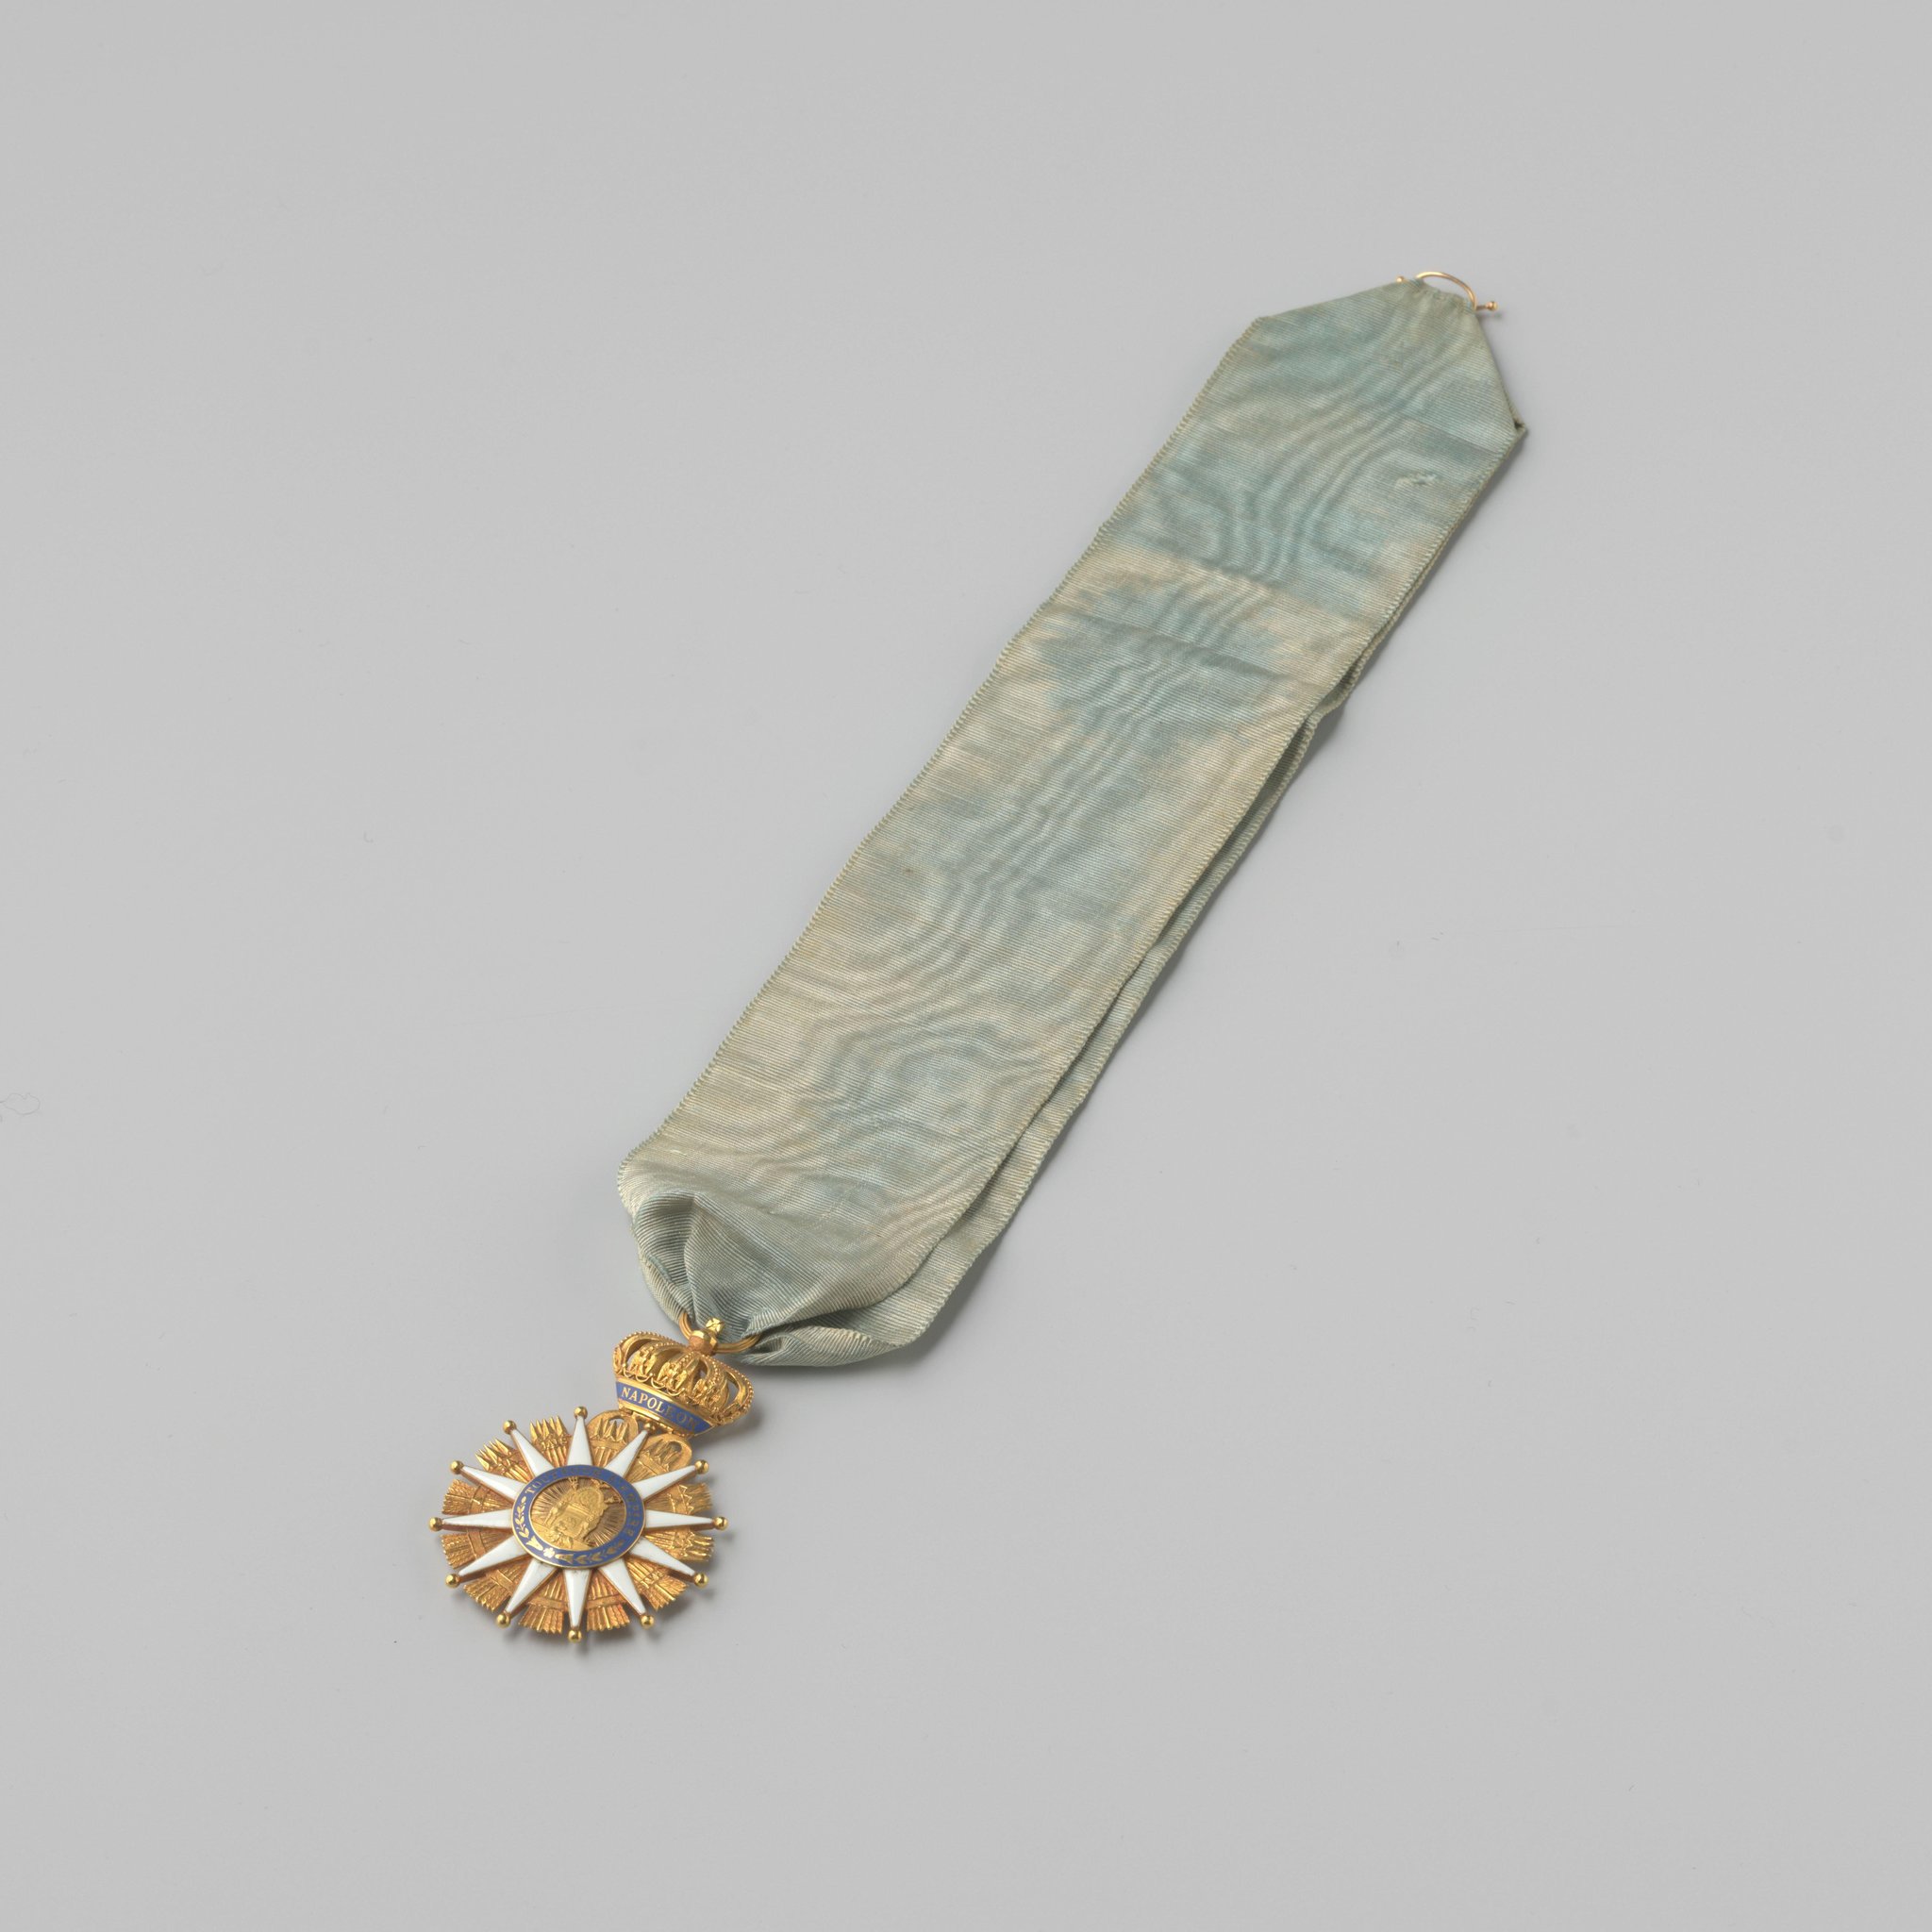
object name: insignia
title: Groot ordeteken van de Orde van de Reunie van vice-admiraal A. A. Buyskes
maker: Anonymous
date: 1811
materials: gold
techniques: casting, forging, sewing, striking, weave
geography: france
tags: napoleon i (emperor of the french)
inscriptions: inscription: ‘NAPOLEON’, edge inscription: ‘TOUT POUR L'EMPIRE’, edge inscription: ‘A JAMAIS’, inscription: ‘FONDATEUR’, inscription: ‘N’, edge inscription: ‘A JAMAIS’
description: Ordeteken bestaande uit een twaalpuntige wit geëmailleerde ster met parels, daartussen pijlenbundel met lint met opschrift, in het midden medaillon met blauwe rand met opschrift. Voorzijde lauwerkrans en opschriften. Keerzijde: troon waarvoor twee kinderen met liggende wolvin. Met scharnier bevestigd aan opengewerkt kroontje, onder voorzien van blauwe band met opschrift, de spijltjes gesteund door adelaars.